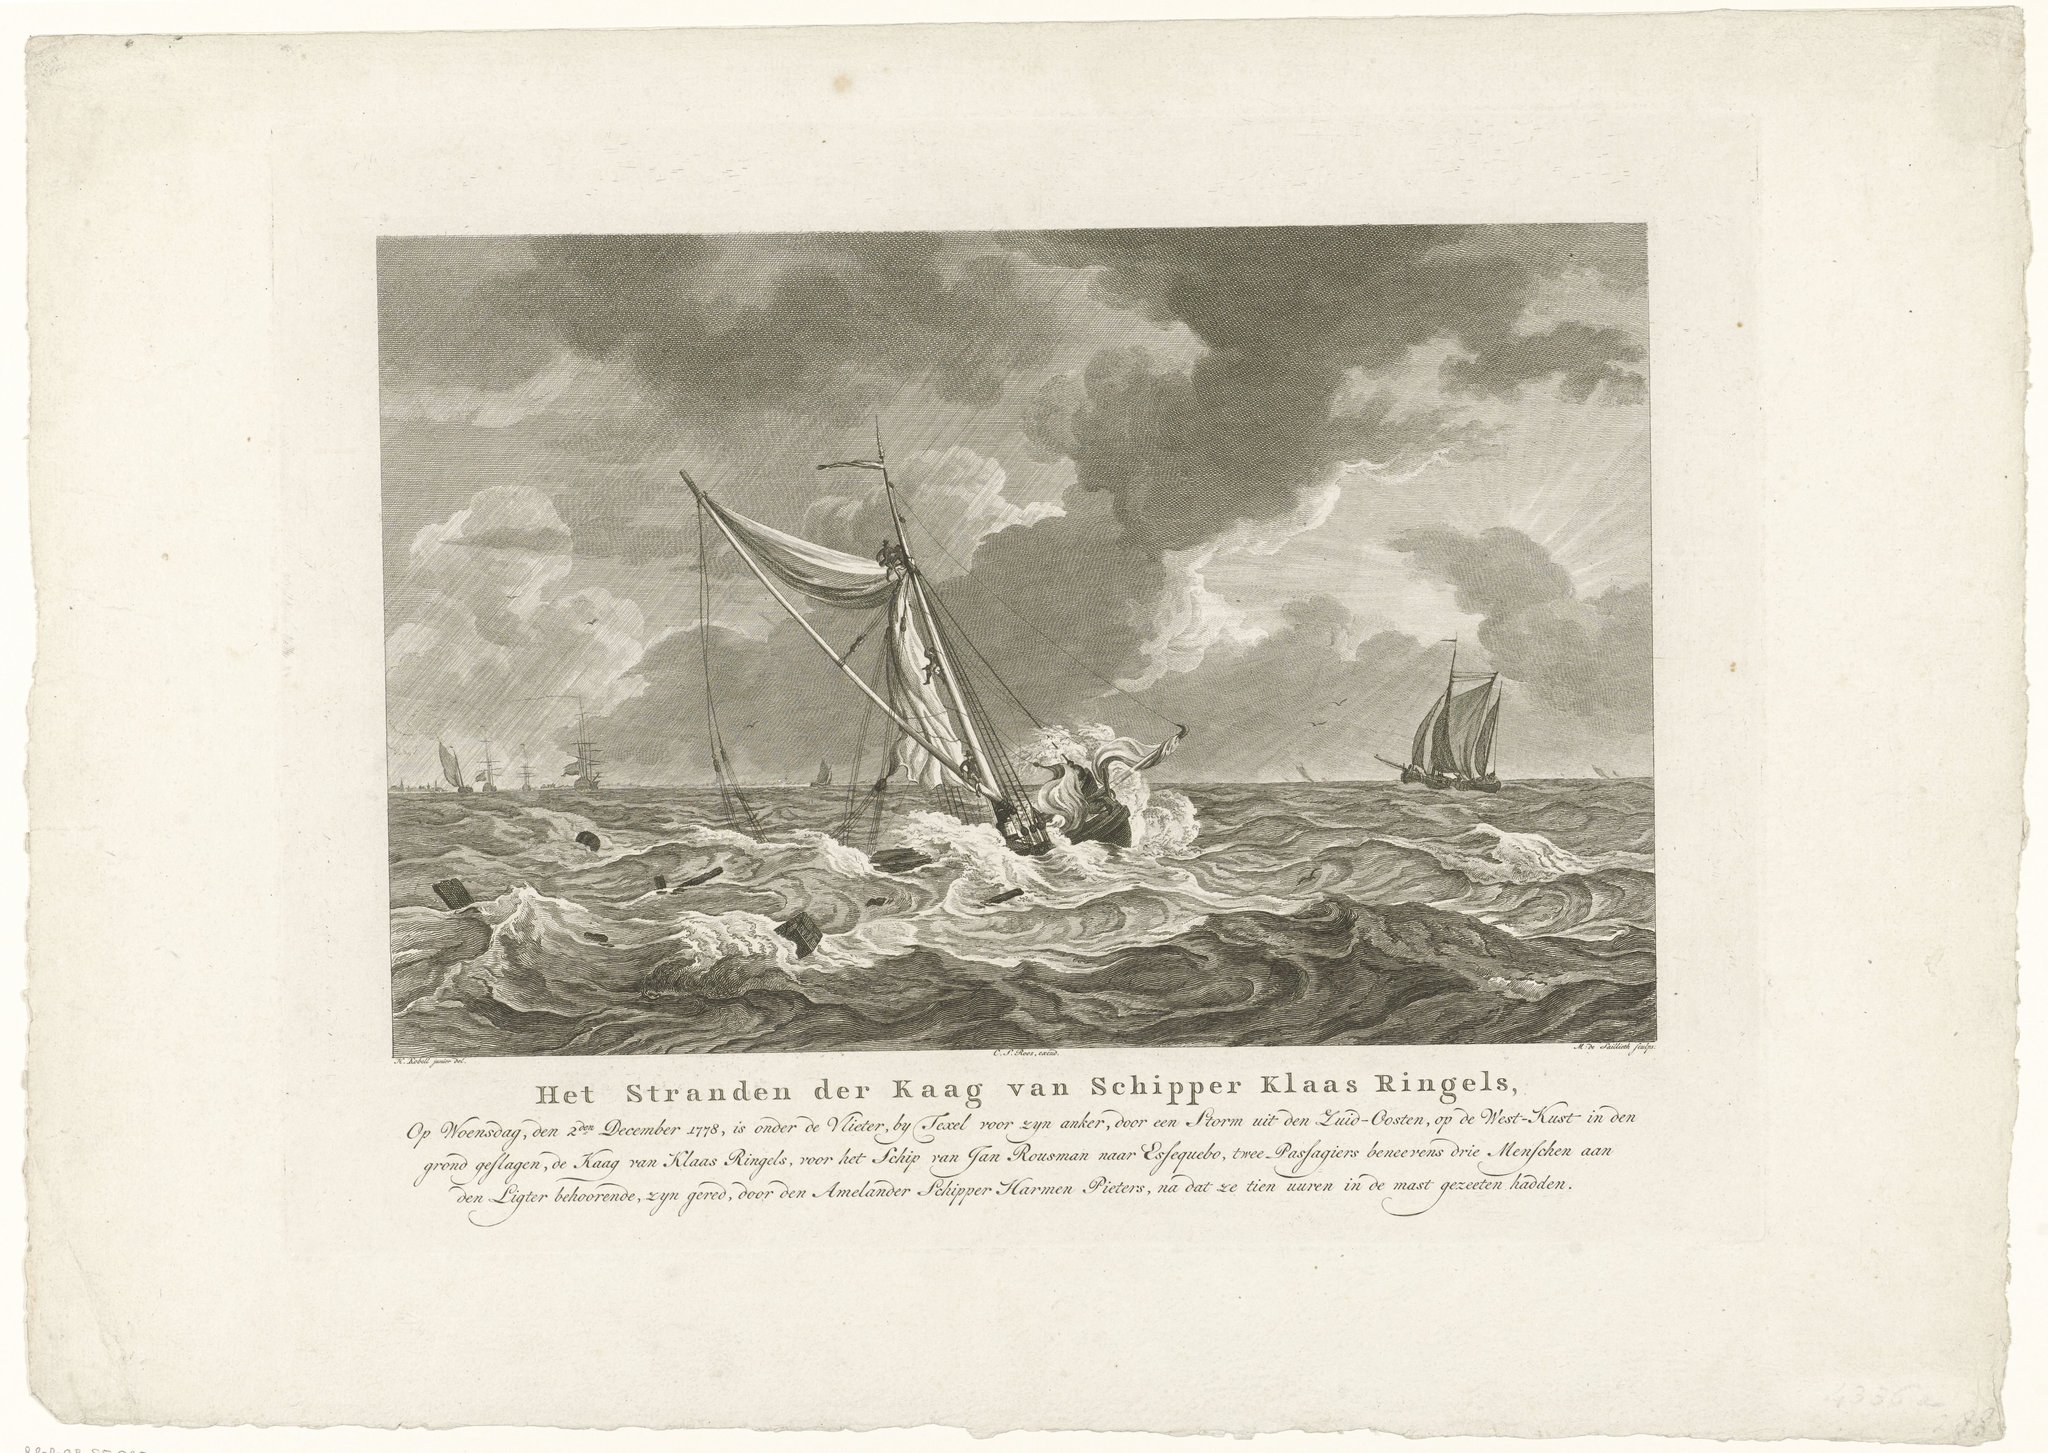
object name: print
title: Stranden van de kaag van schipper Klaas Ringels bij Texel, 1778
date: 1779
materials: paper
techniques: engraving, etching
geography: rotterdam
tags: shipwreck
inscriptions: collector's mark: Lugt 2228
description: Het stranden van de kaag van schipper Klaas Ringels tijdens een storm bij Texel, op 2 december 1778. De vijf personen aan boord werden gered door de Amelander schipper Harmen Pieters, nadat ze tien uur in de mast hadden gezeten. In het onderschrift de titel en drie regels tekst.